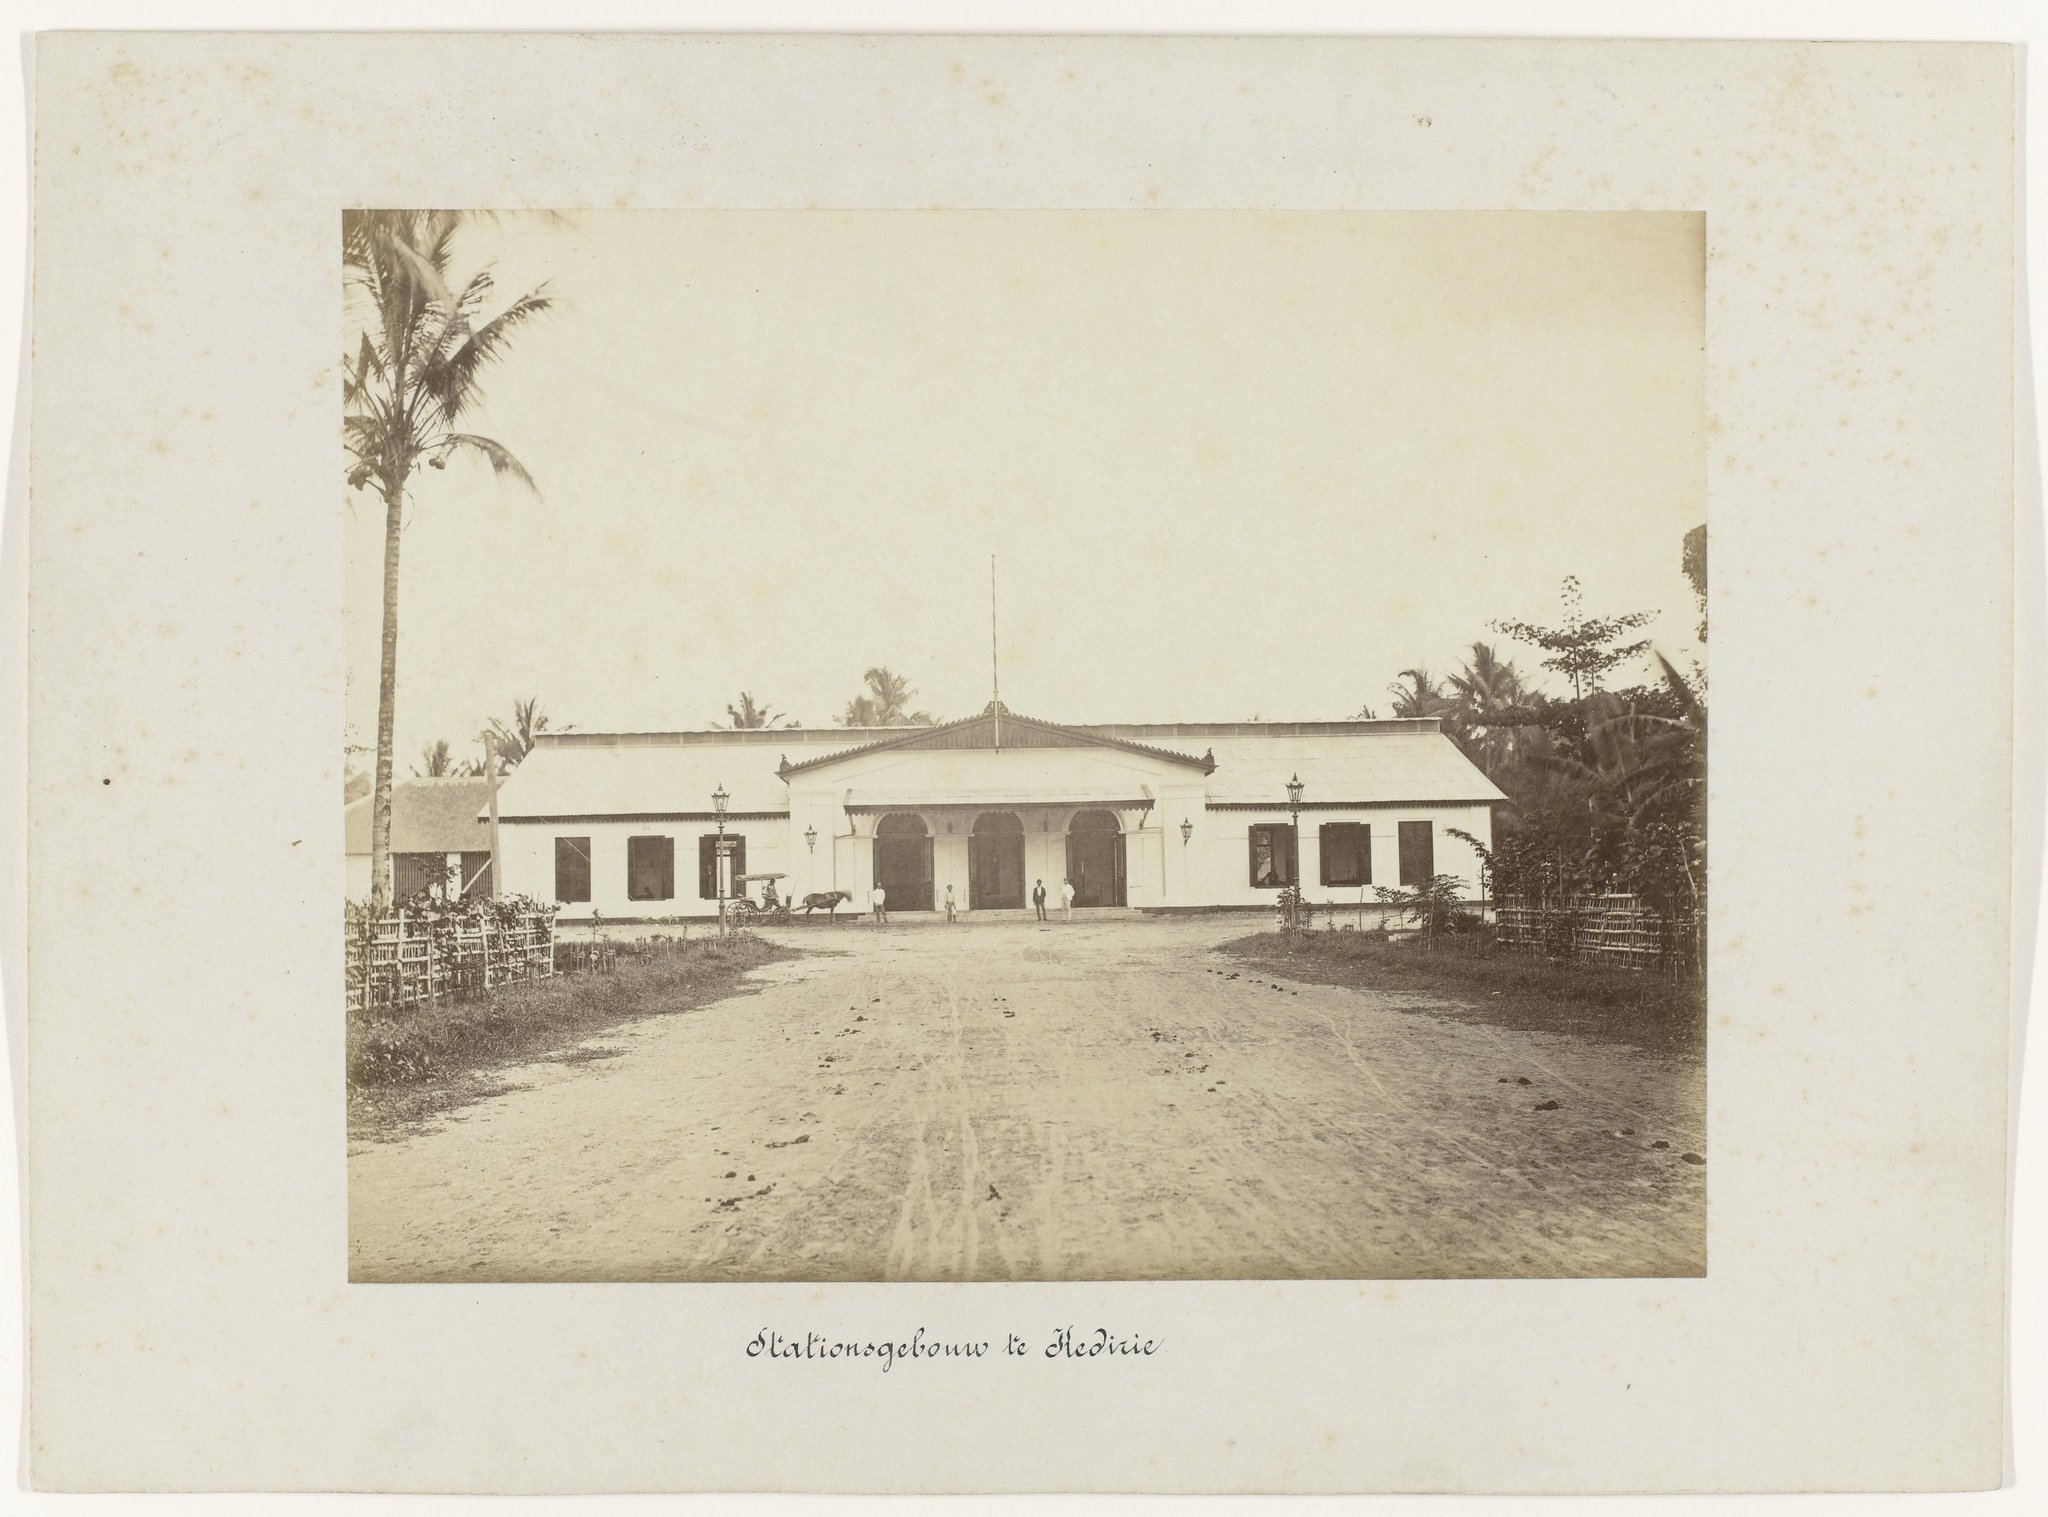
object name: photograph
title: Staatsspoorwegen op Java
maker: Anonymous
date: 1880-1888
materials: photographic support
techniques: albumen print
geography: java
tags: kediri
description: De buitenkant van het stationsgebouw te Kedirie, voor de ingang enkele mannen en een koets. Onderdeel van een groep van 62 foto's in een doos met het opschrift "Staatsspoorwegen op Java" uit 1888.